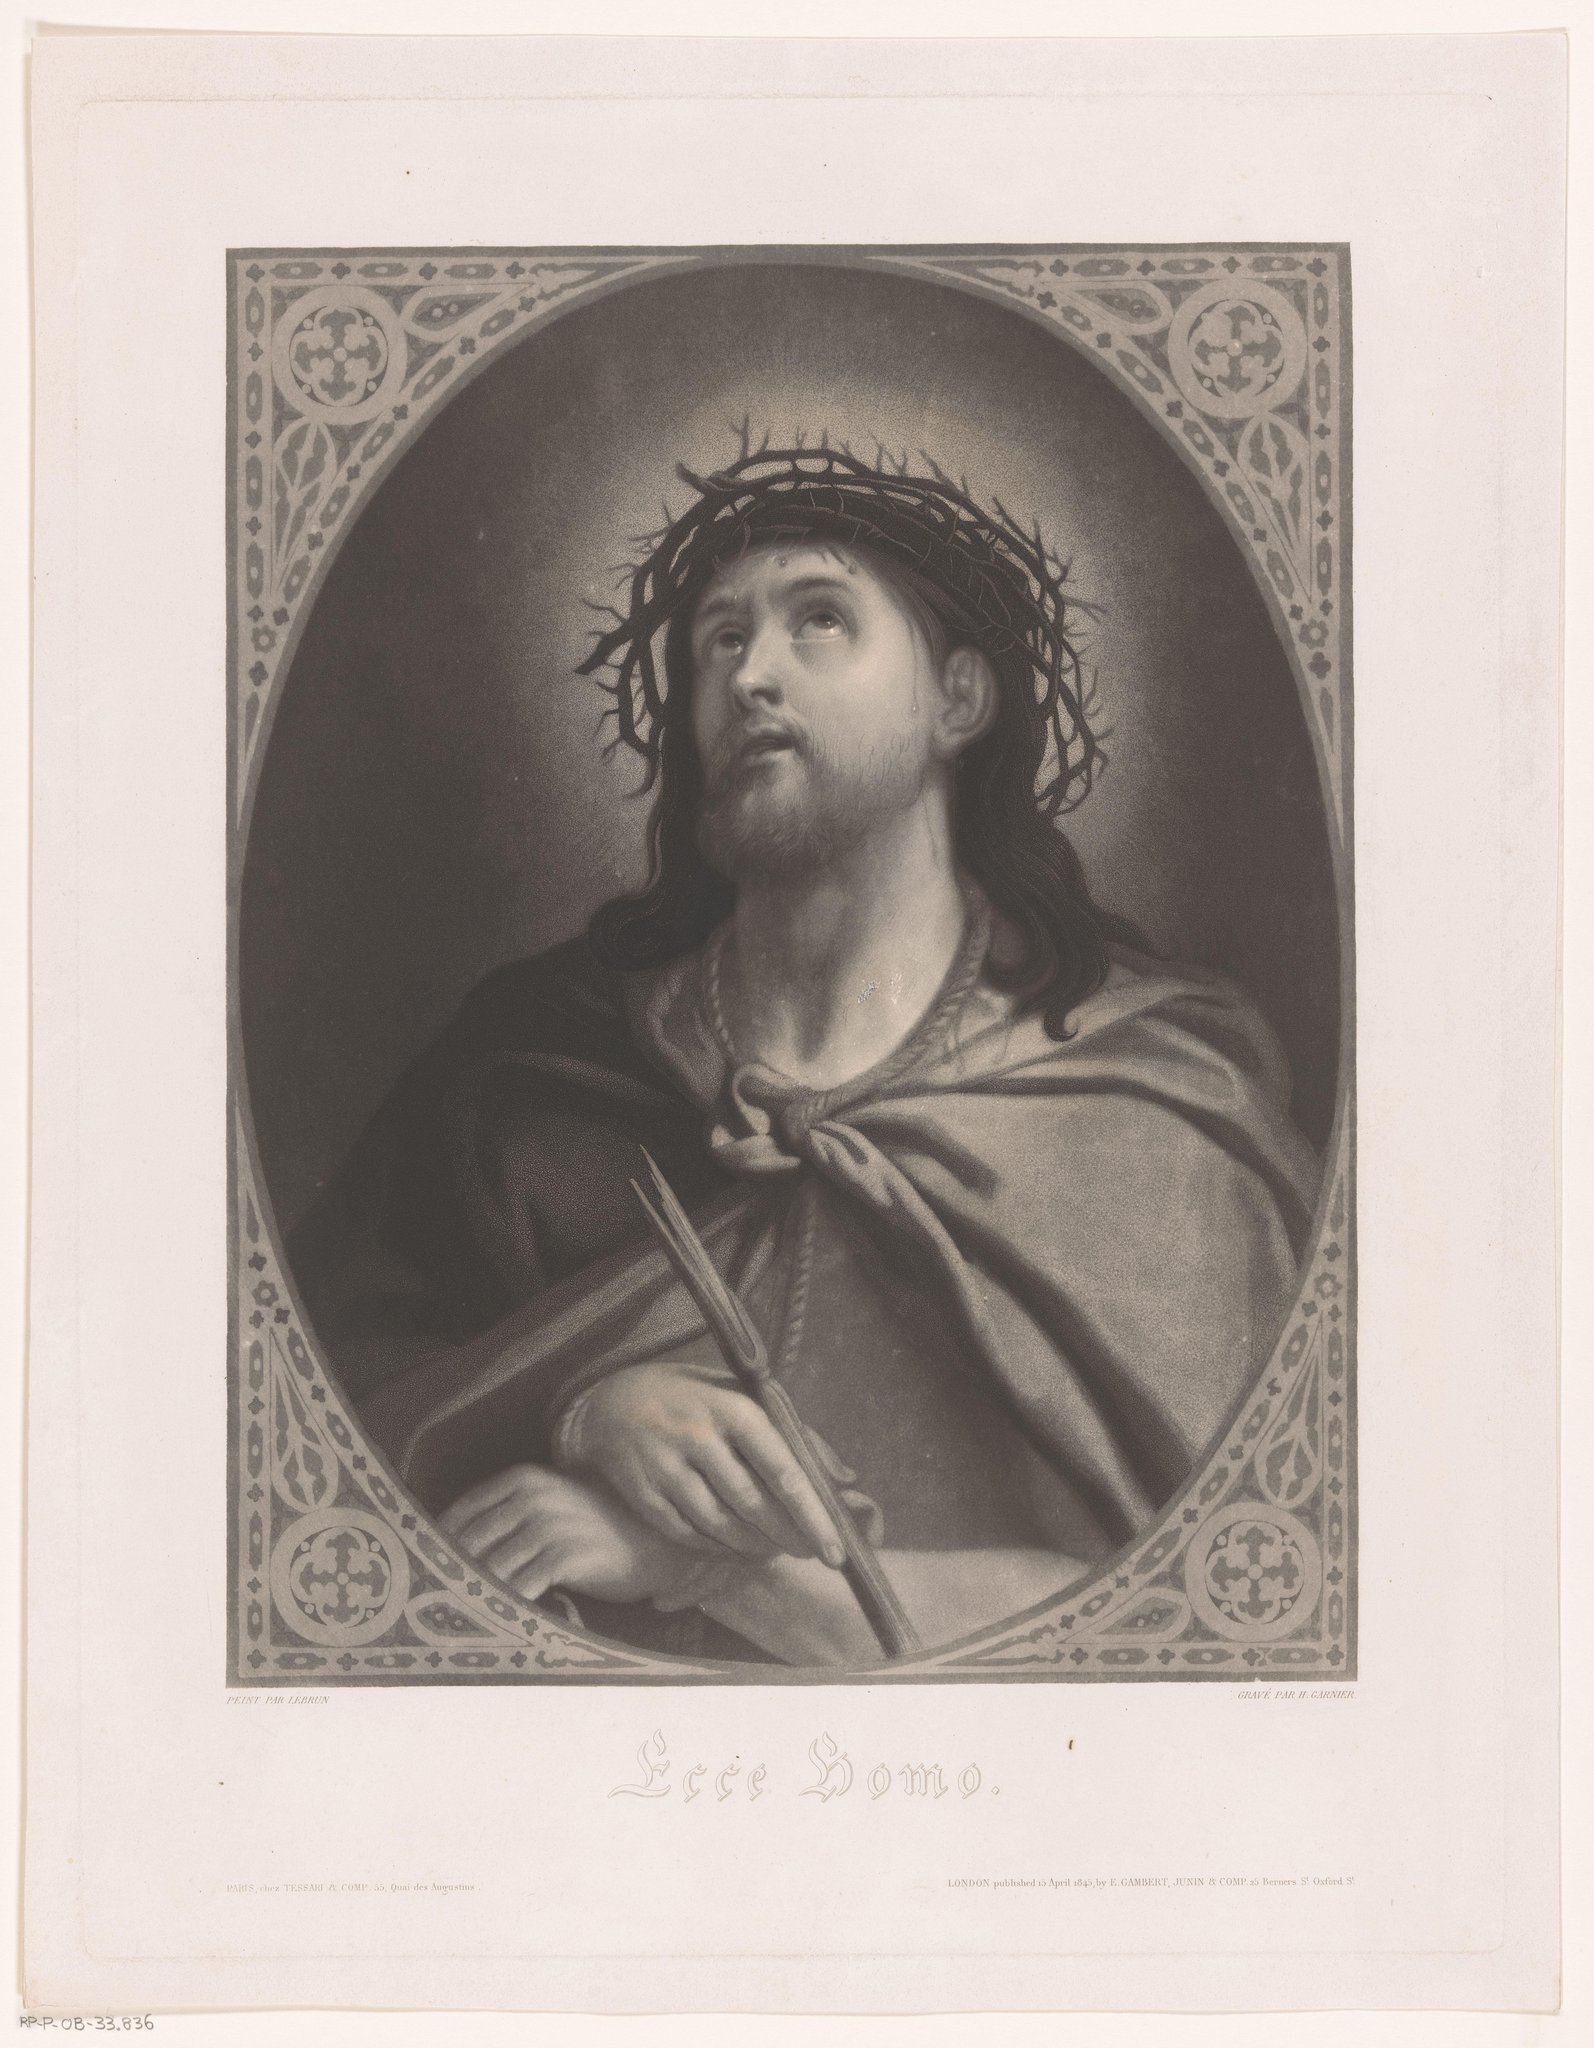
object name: print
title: Ecce Homo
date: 1845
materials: paper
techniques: etching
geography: paris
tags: christ alone (also called 'ecce homo')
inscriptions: collector's mark: Lugt 2228